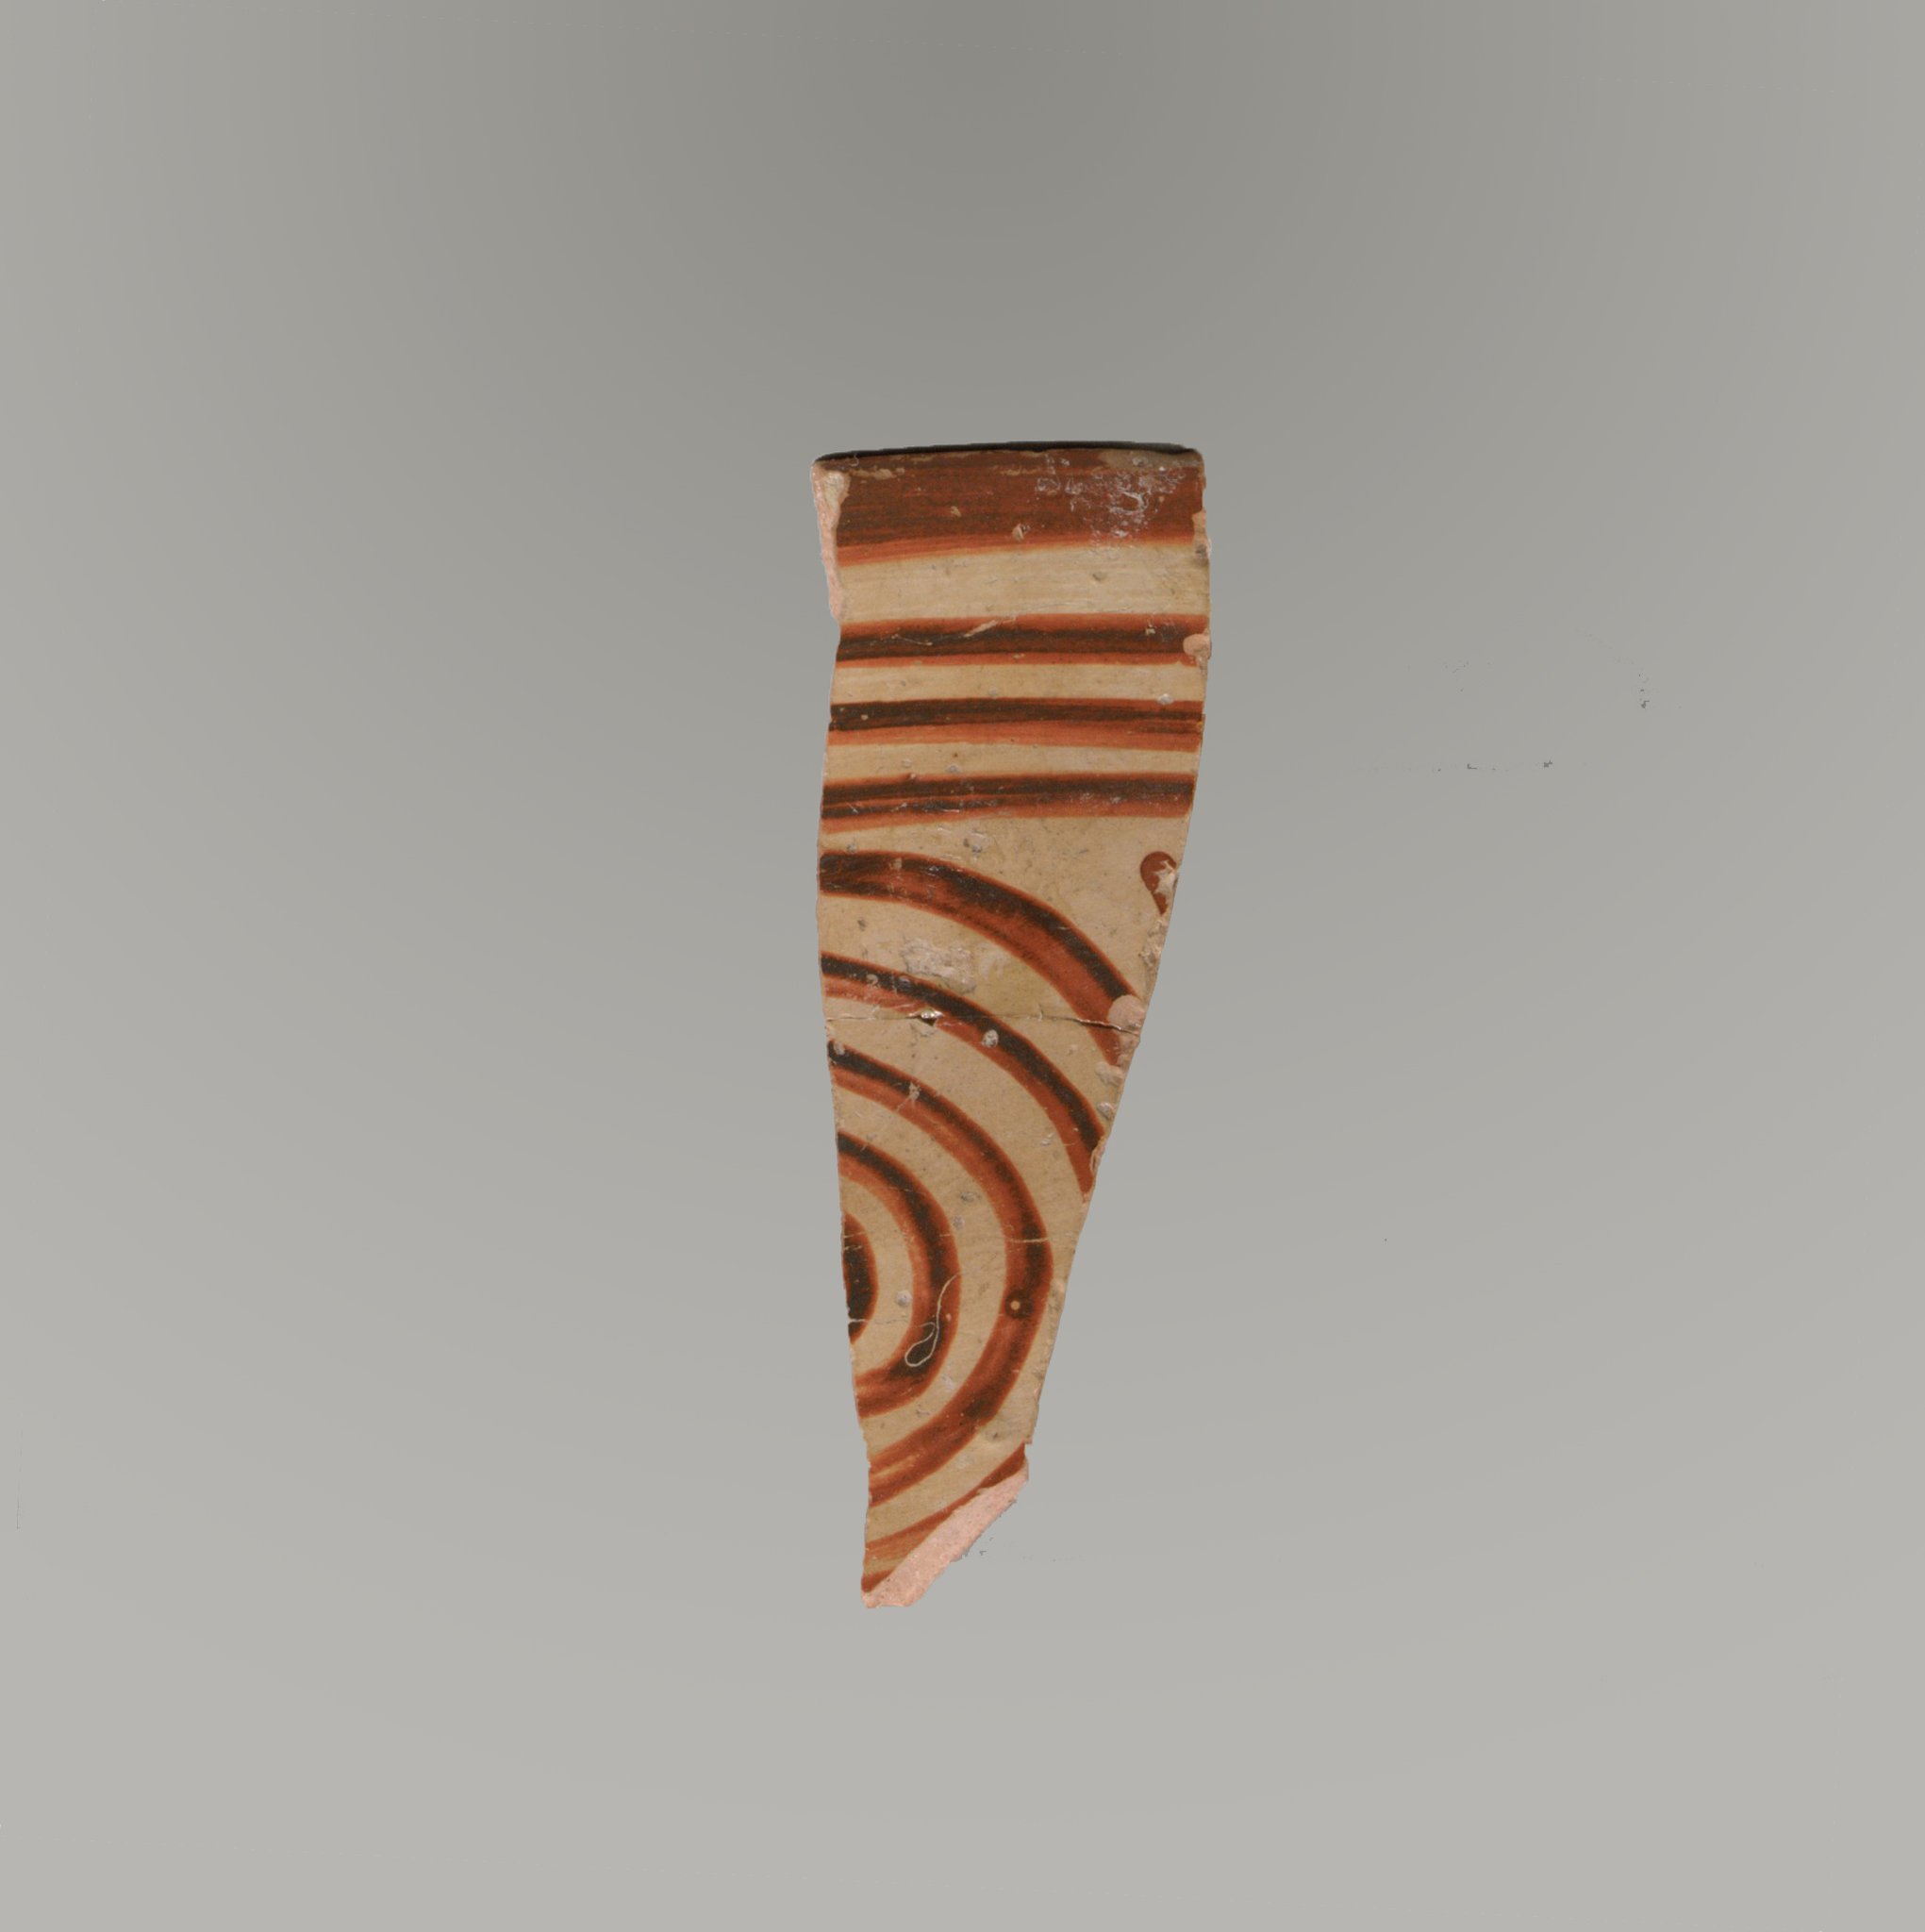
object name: vase fragment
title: Terracotta rim and upper body fragment with concentric circles (or spiral?) and bands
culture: minoan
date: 1400-1200 BCE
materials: terracotta